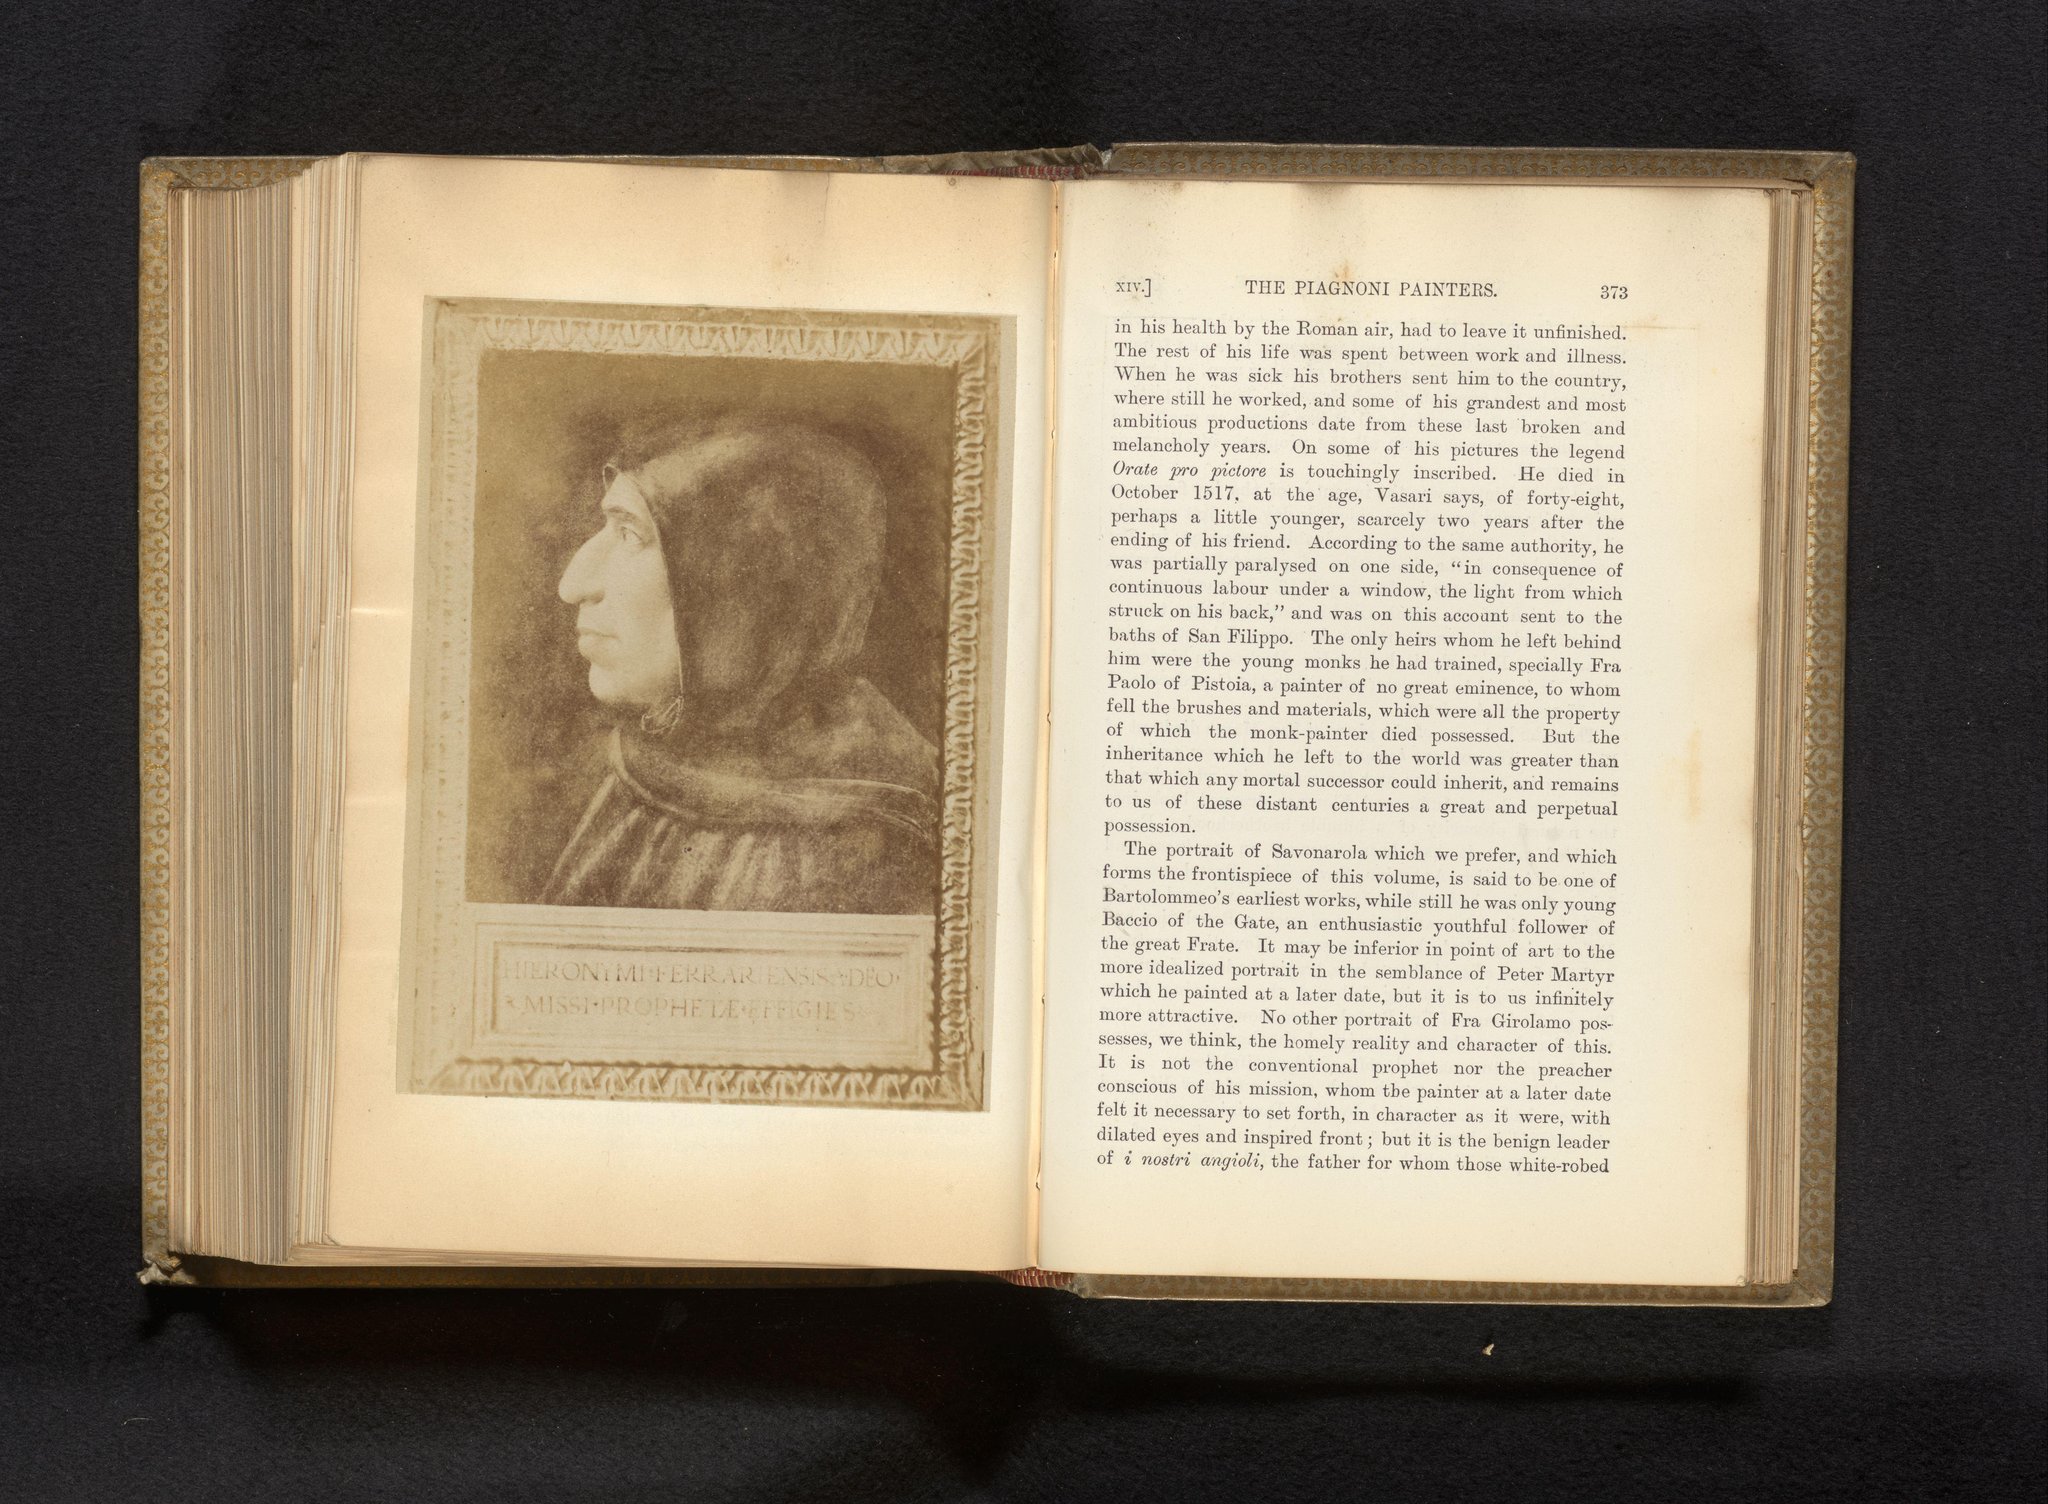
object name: photograph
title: Fotoreproductie van een schilderij, voorstellende een portret van Girolamo Savonarola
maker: Anonymous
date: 1878-1888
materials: photographic support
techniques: albumen print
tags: politician, monk(s), friar(s)